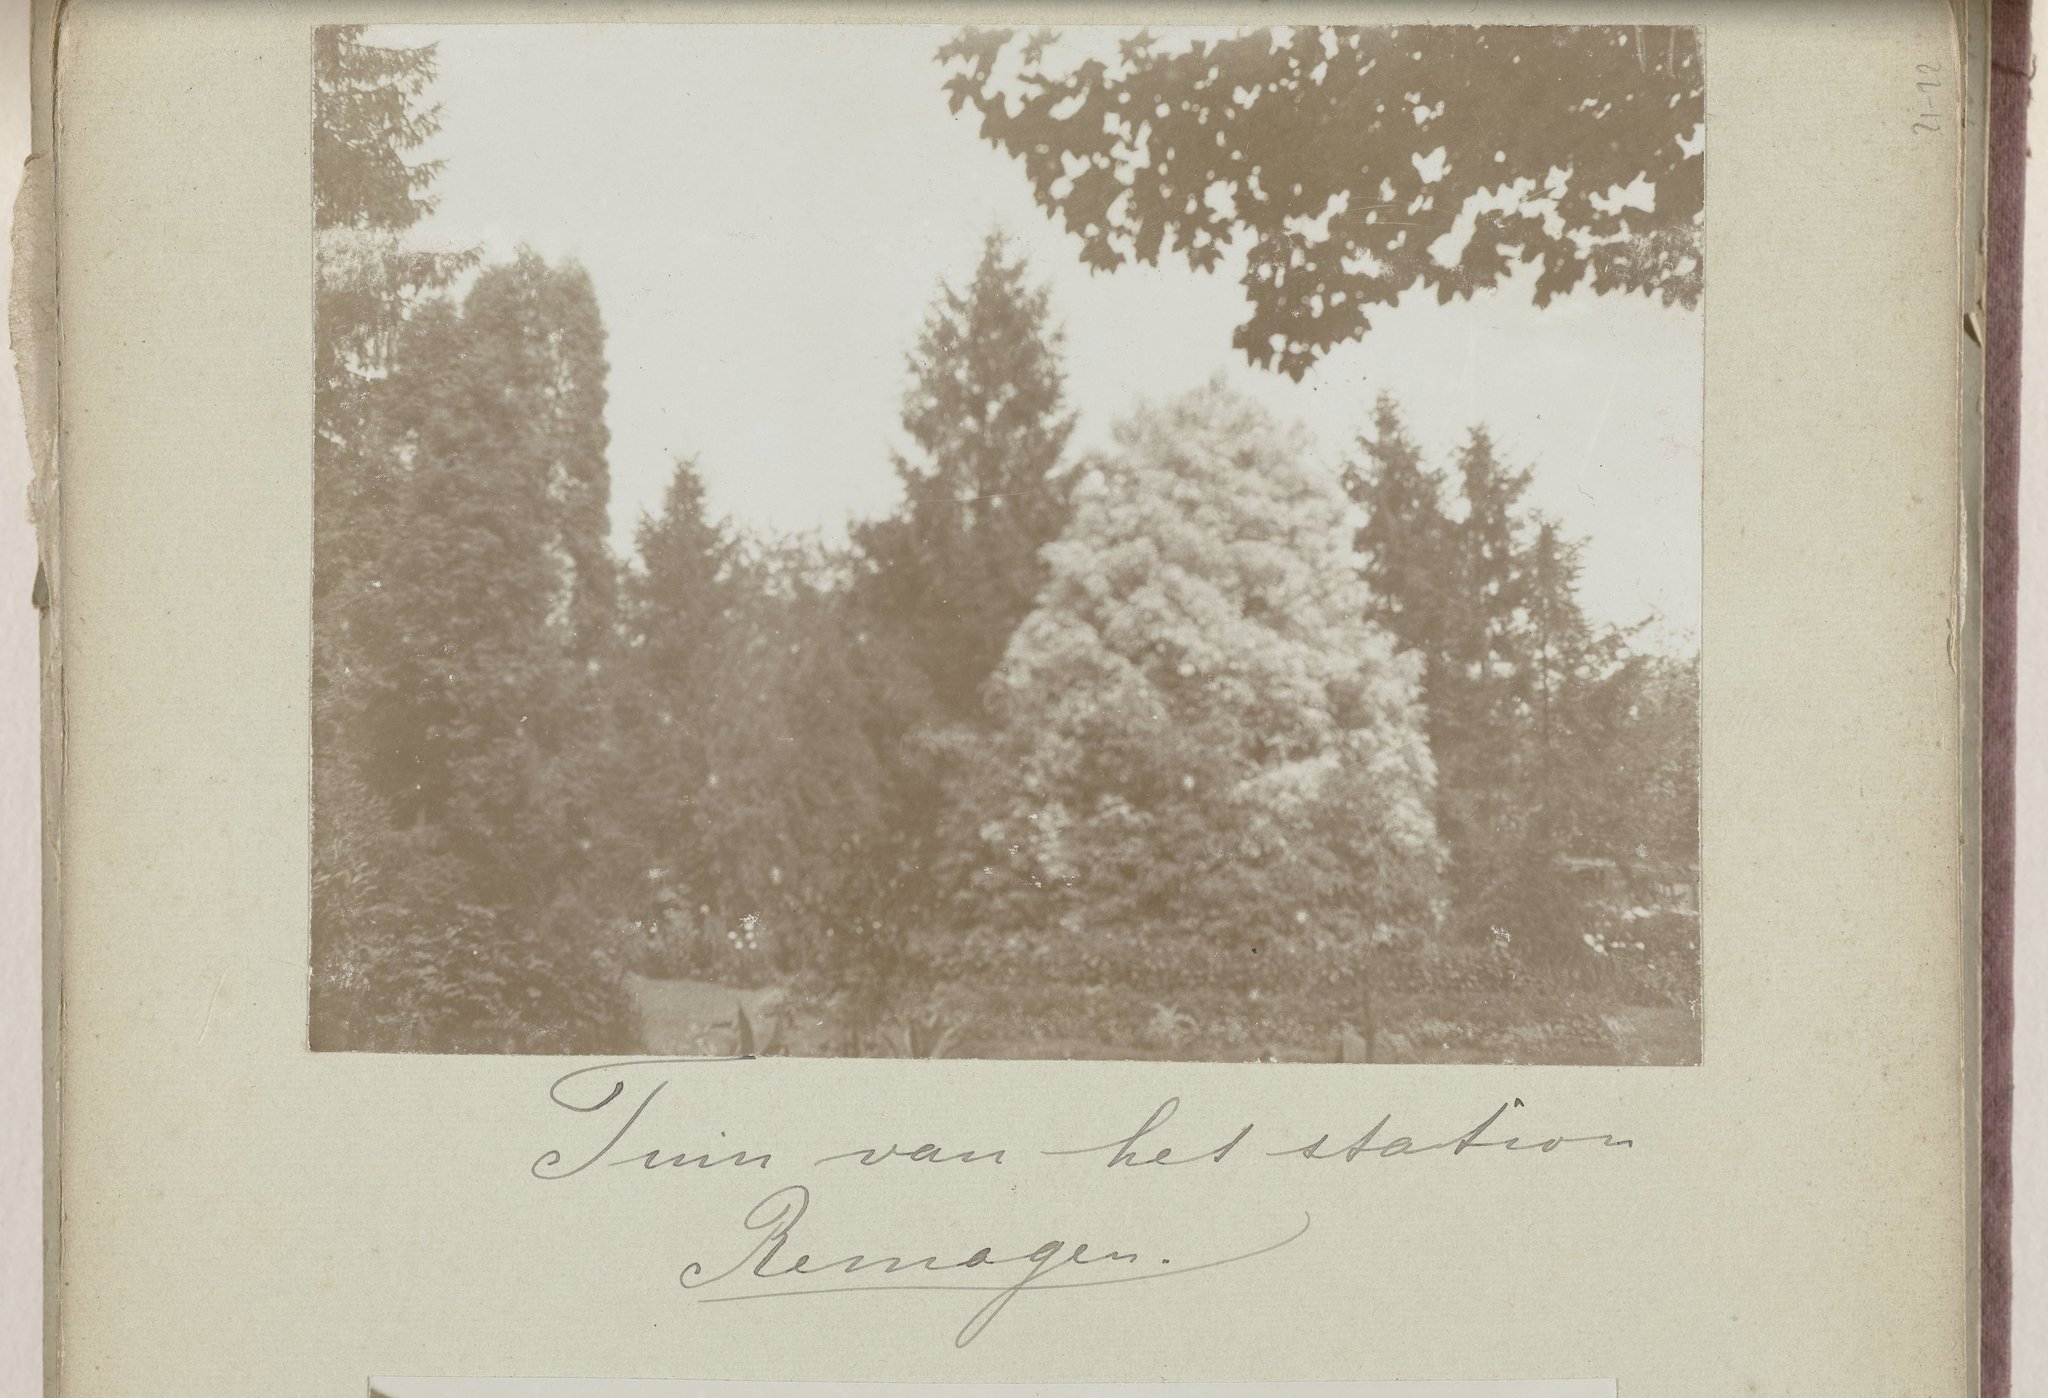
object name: album leaf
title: Tuin met bomen bij het station van Remagen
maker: david vermeulen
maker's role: fotograaf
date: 1895-1905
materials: paper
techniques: collodion silver print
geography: remagen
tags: trees